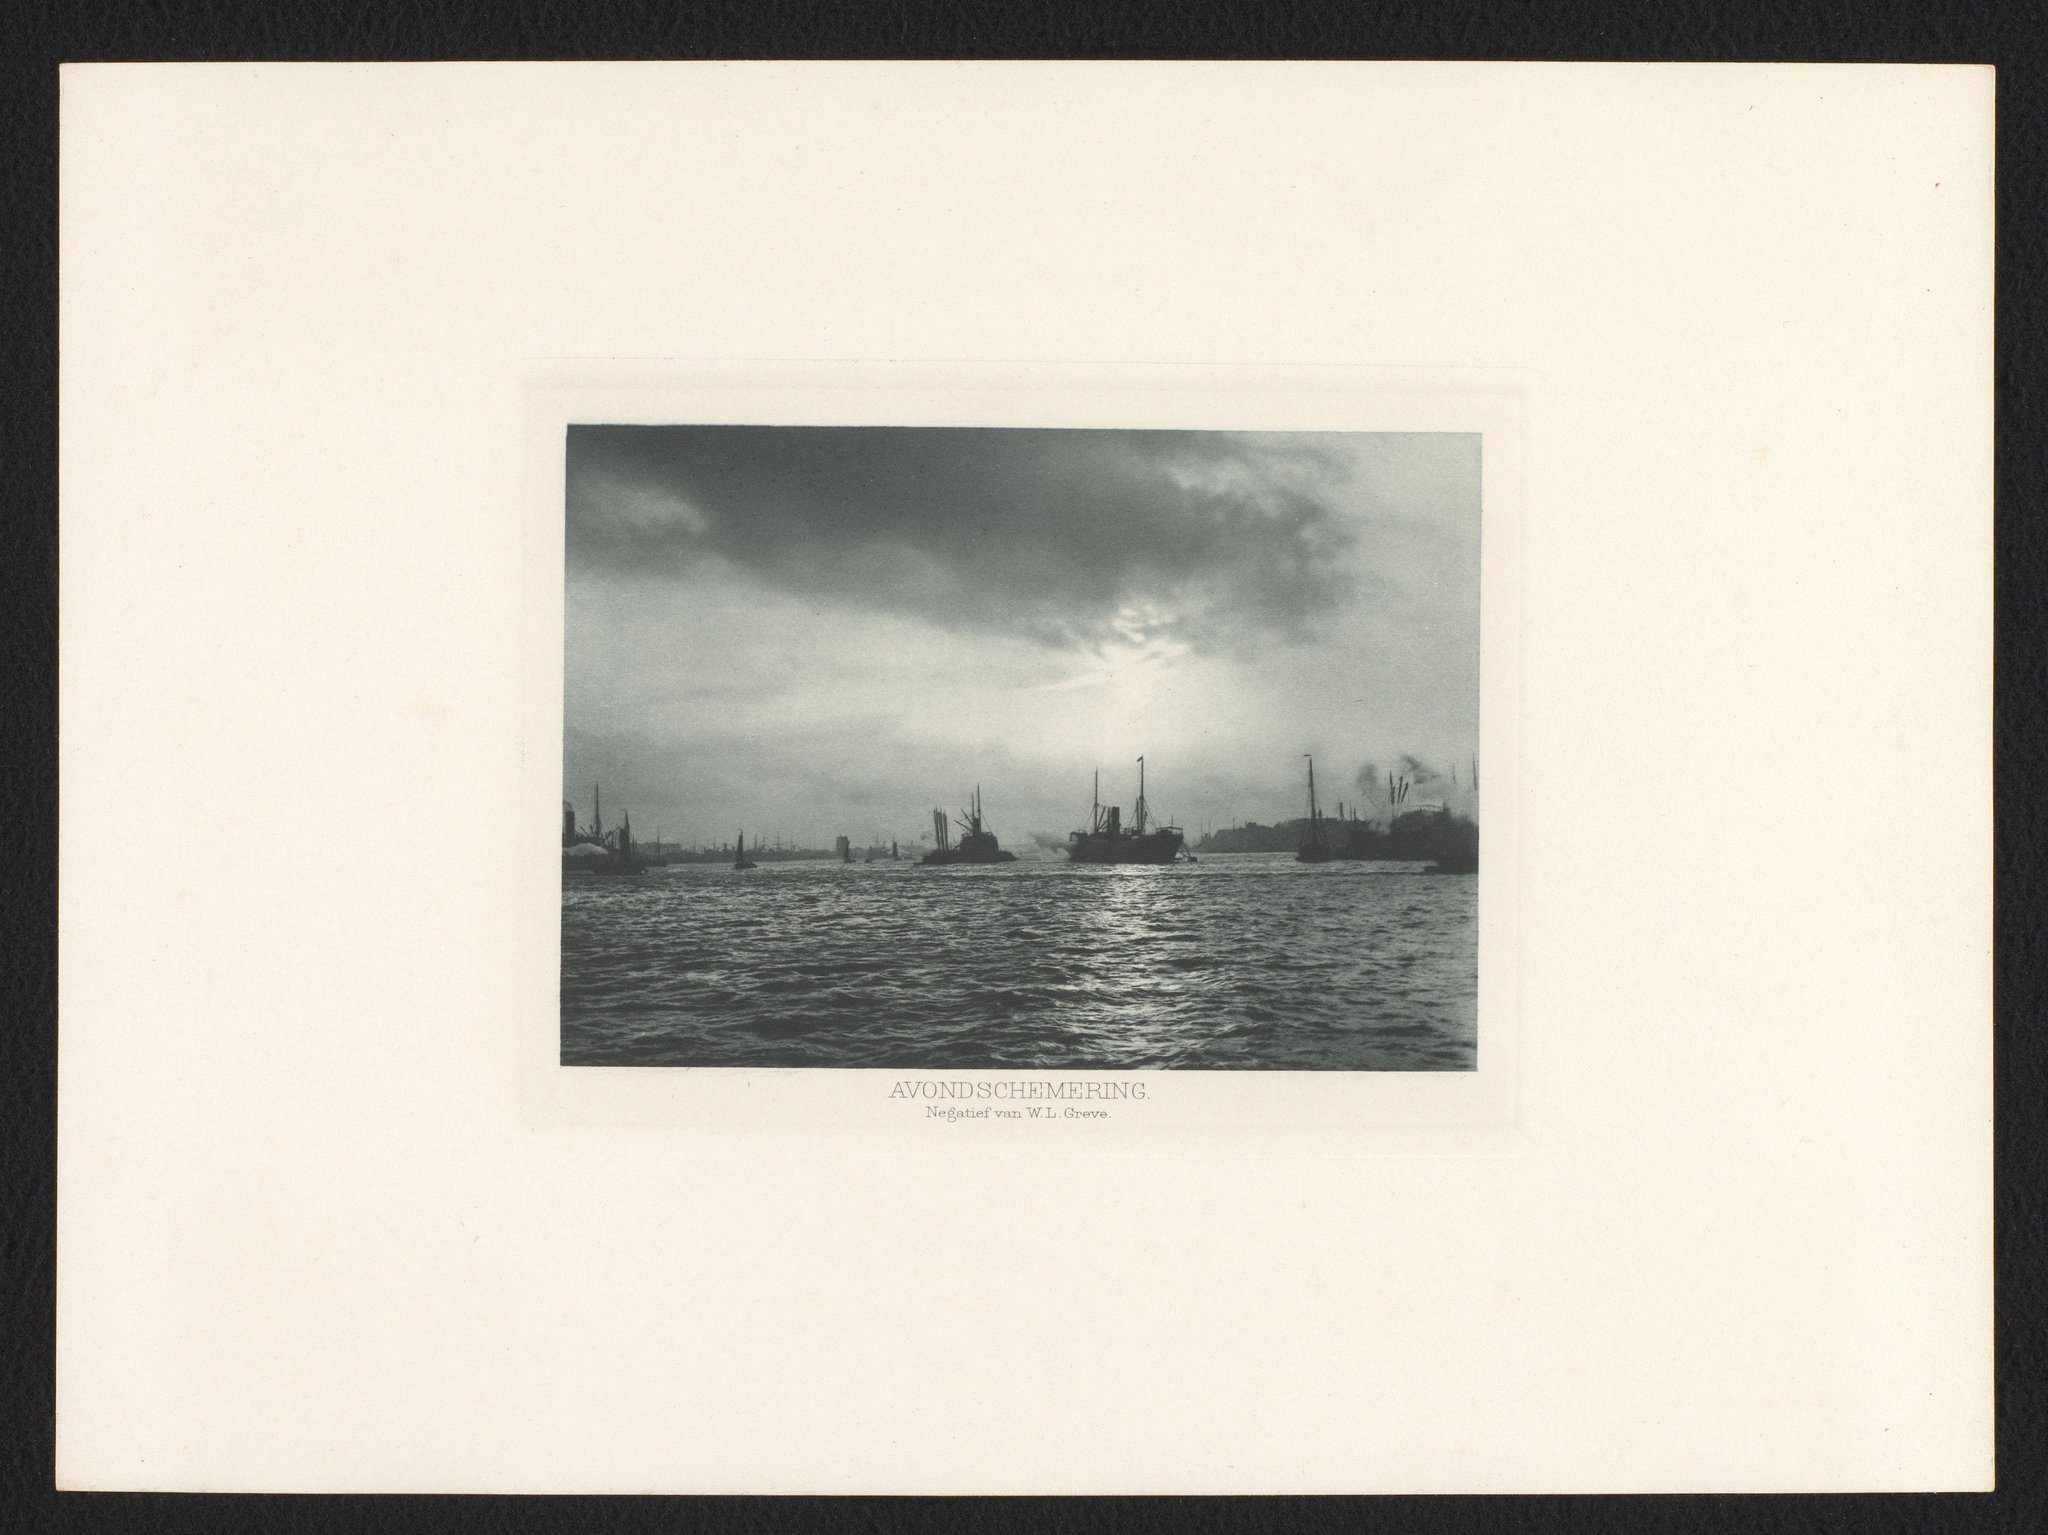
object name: photomechanical print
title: Schepen te water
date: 1899-1904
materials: paper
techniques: photoaquatint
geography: netherlands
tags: river, ships (in general), sea (seascape)